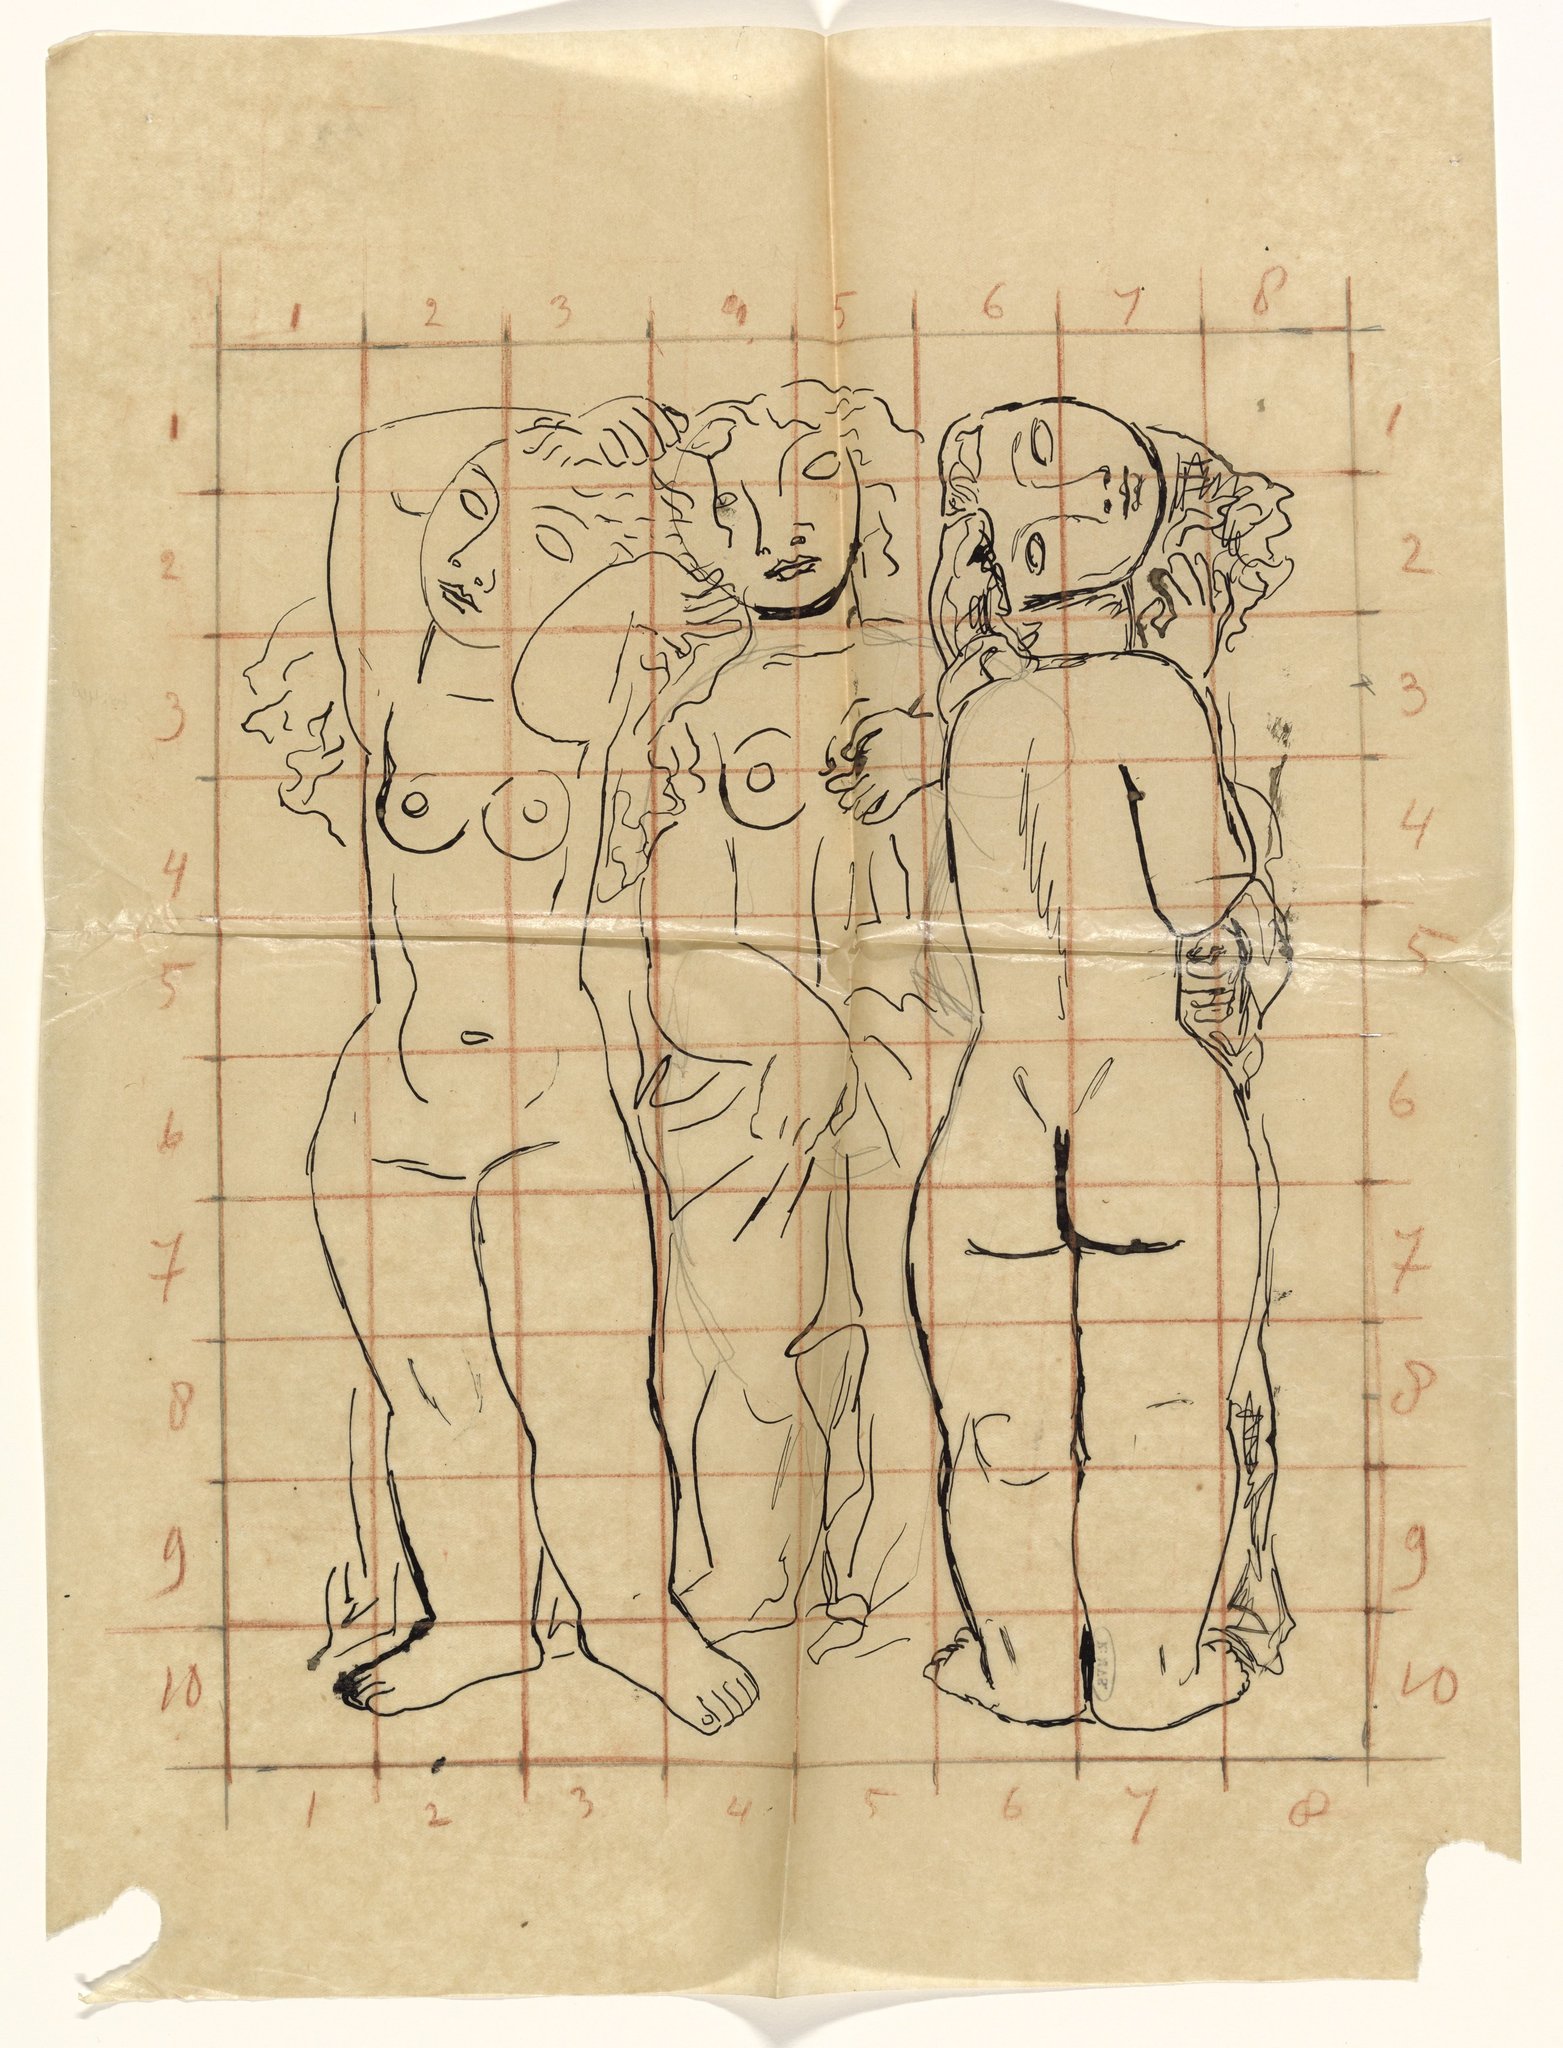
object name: drawing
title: Drie naakte staande vrouwen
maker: leo gestel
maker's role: draughtsman, print maker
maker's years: 1881-1941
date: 1891-1941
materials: chalk, ink, pencil, paper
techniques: pen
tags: standing figure - aa - female human figure (+ nude human being)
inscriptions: collector's mark: Lugt 2228